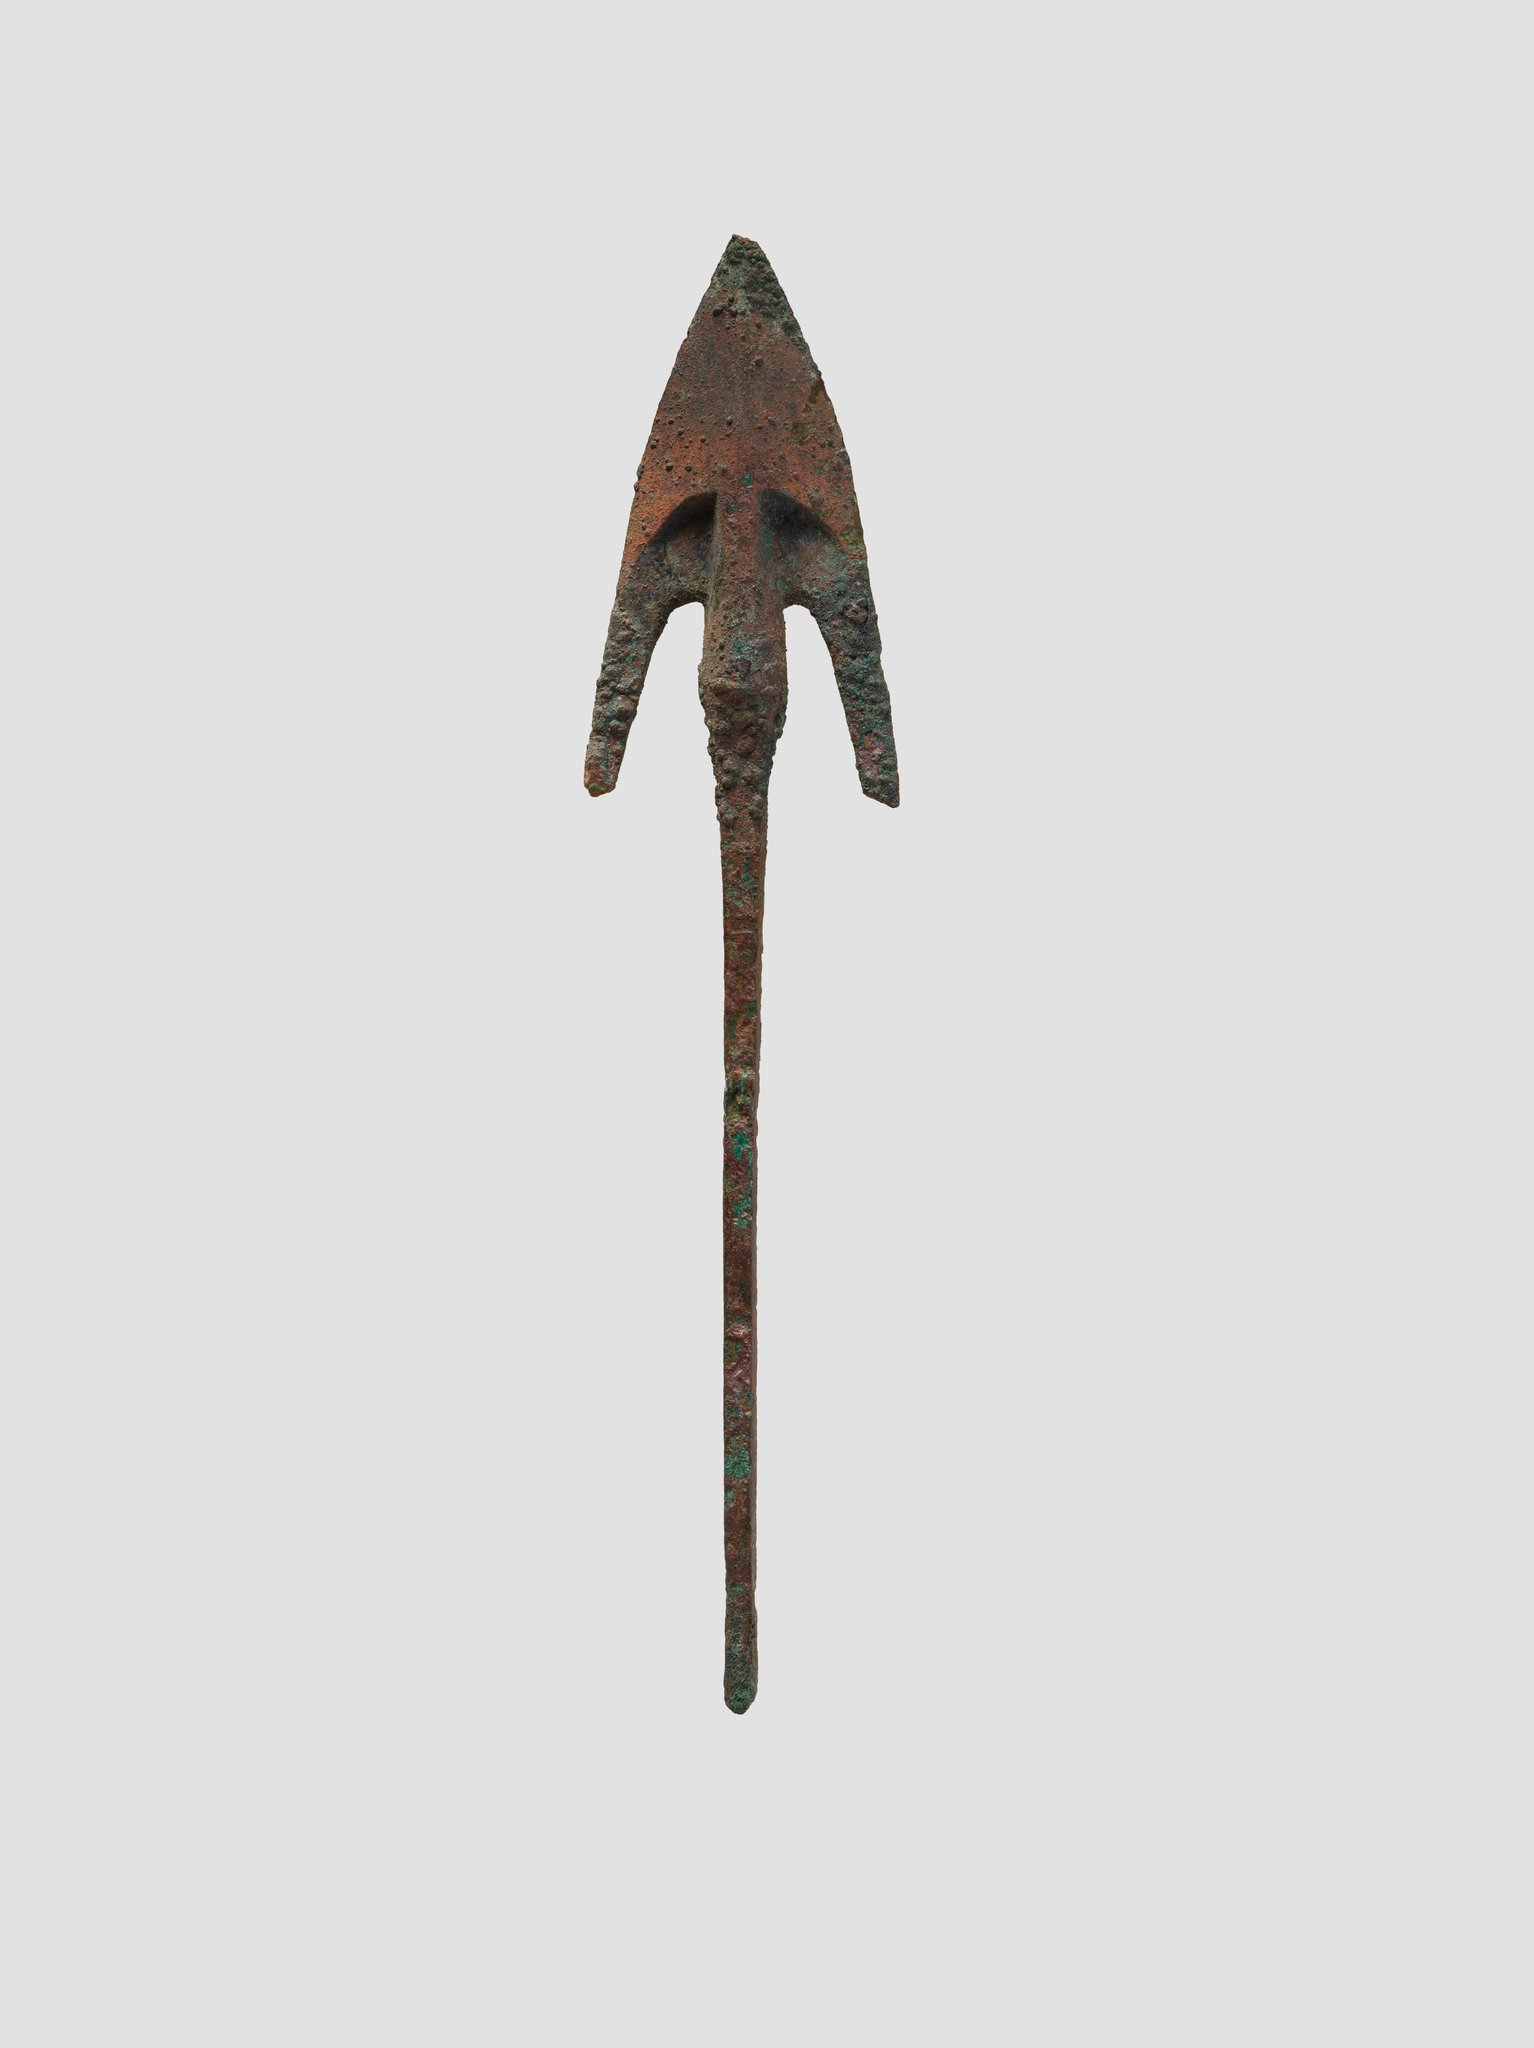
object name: arrowhead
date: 1000-668 BCE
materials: bronze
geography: transcaucasia